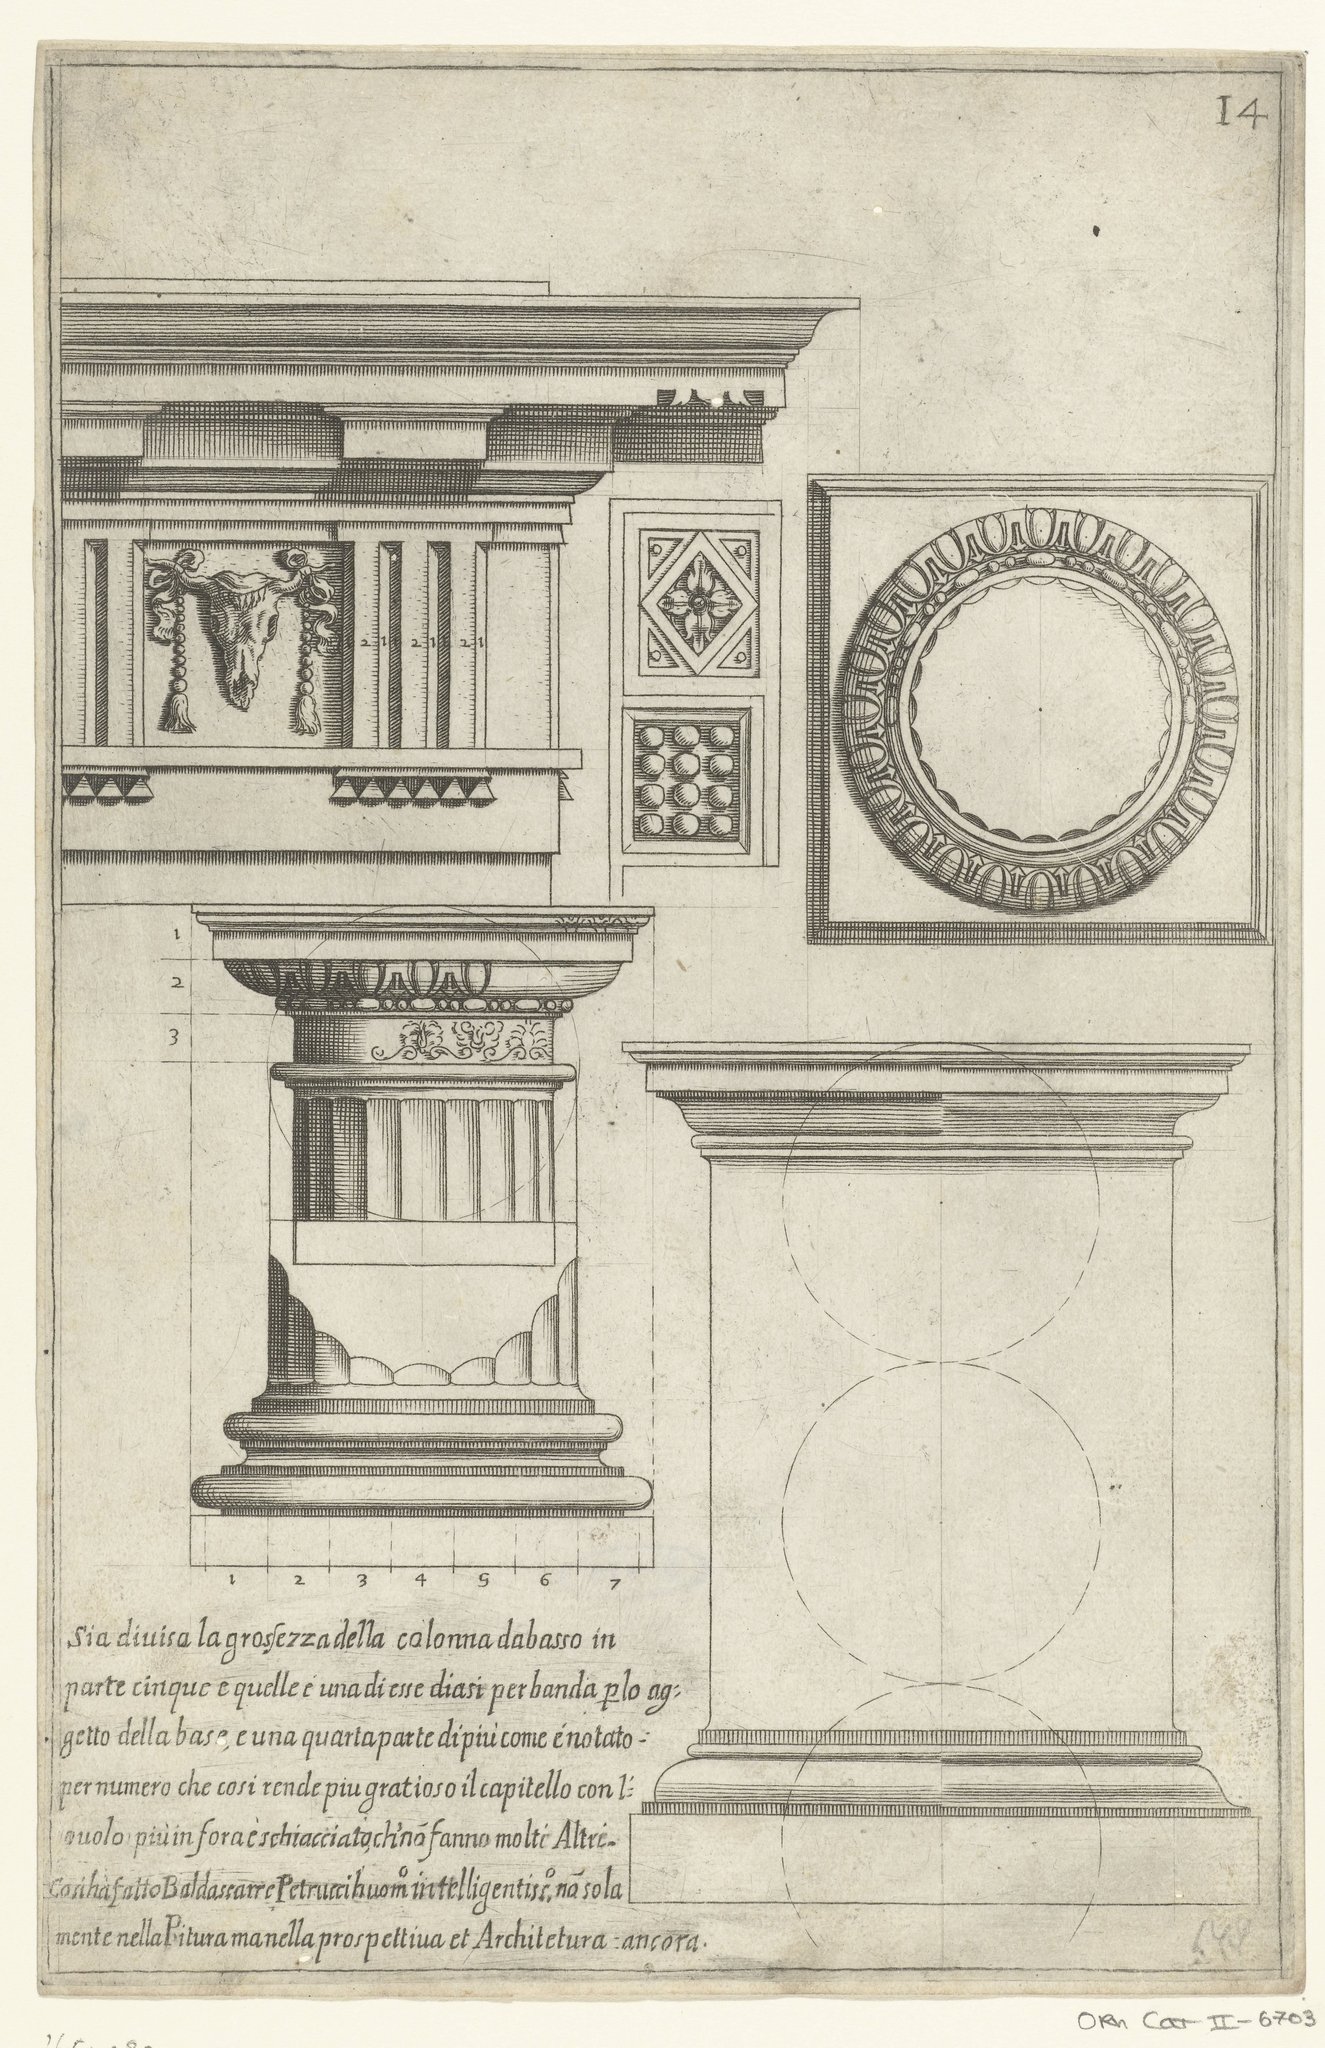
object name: print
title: Details van de Dorische orde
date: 1636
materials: paper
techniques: engraving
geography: rome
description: Basement, kapiteel, hoofdgestel, onderkant van de kroonlijst en voetstuk van de Dorische orde. Linksonder staat uitleg. Uit eerste editie.